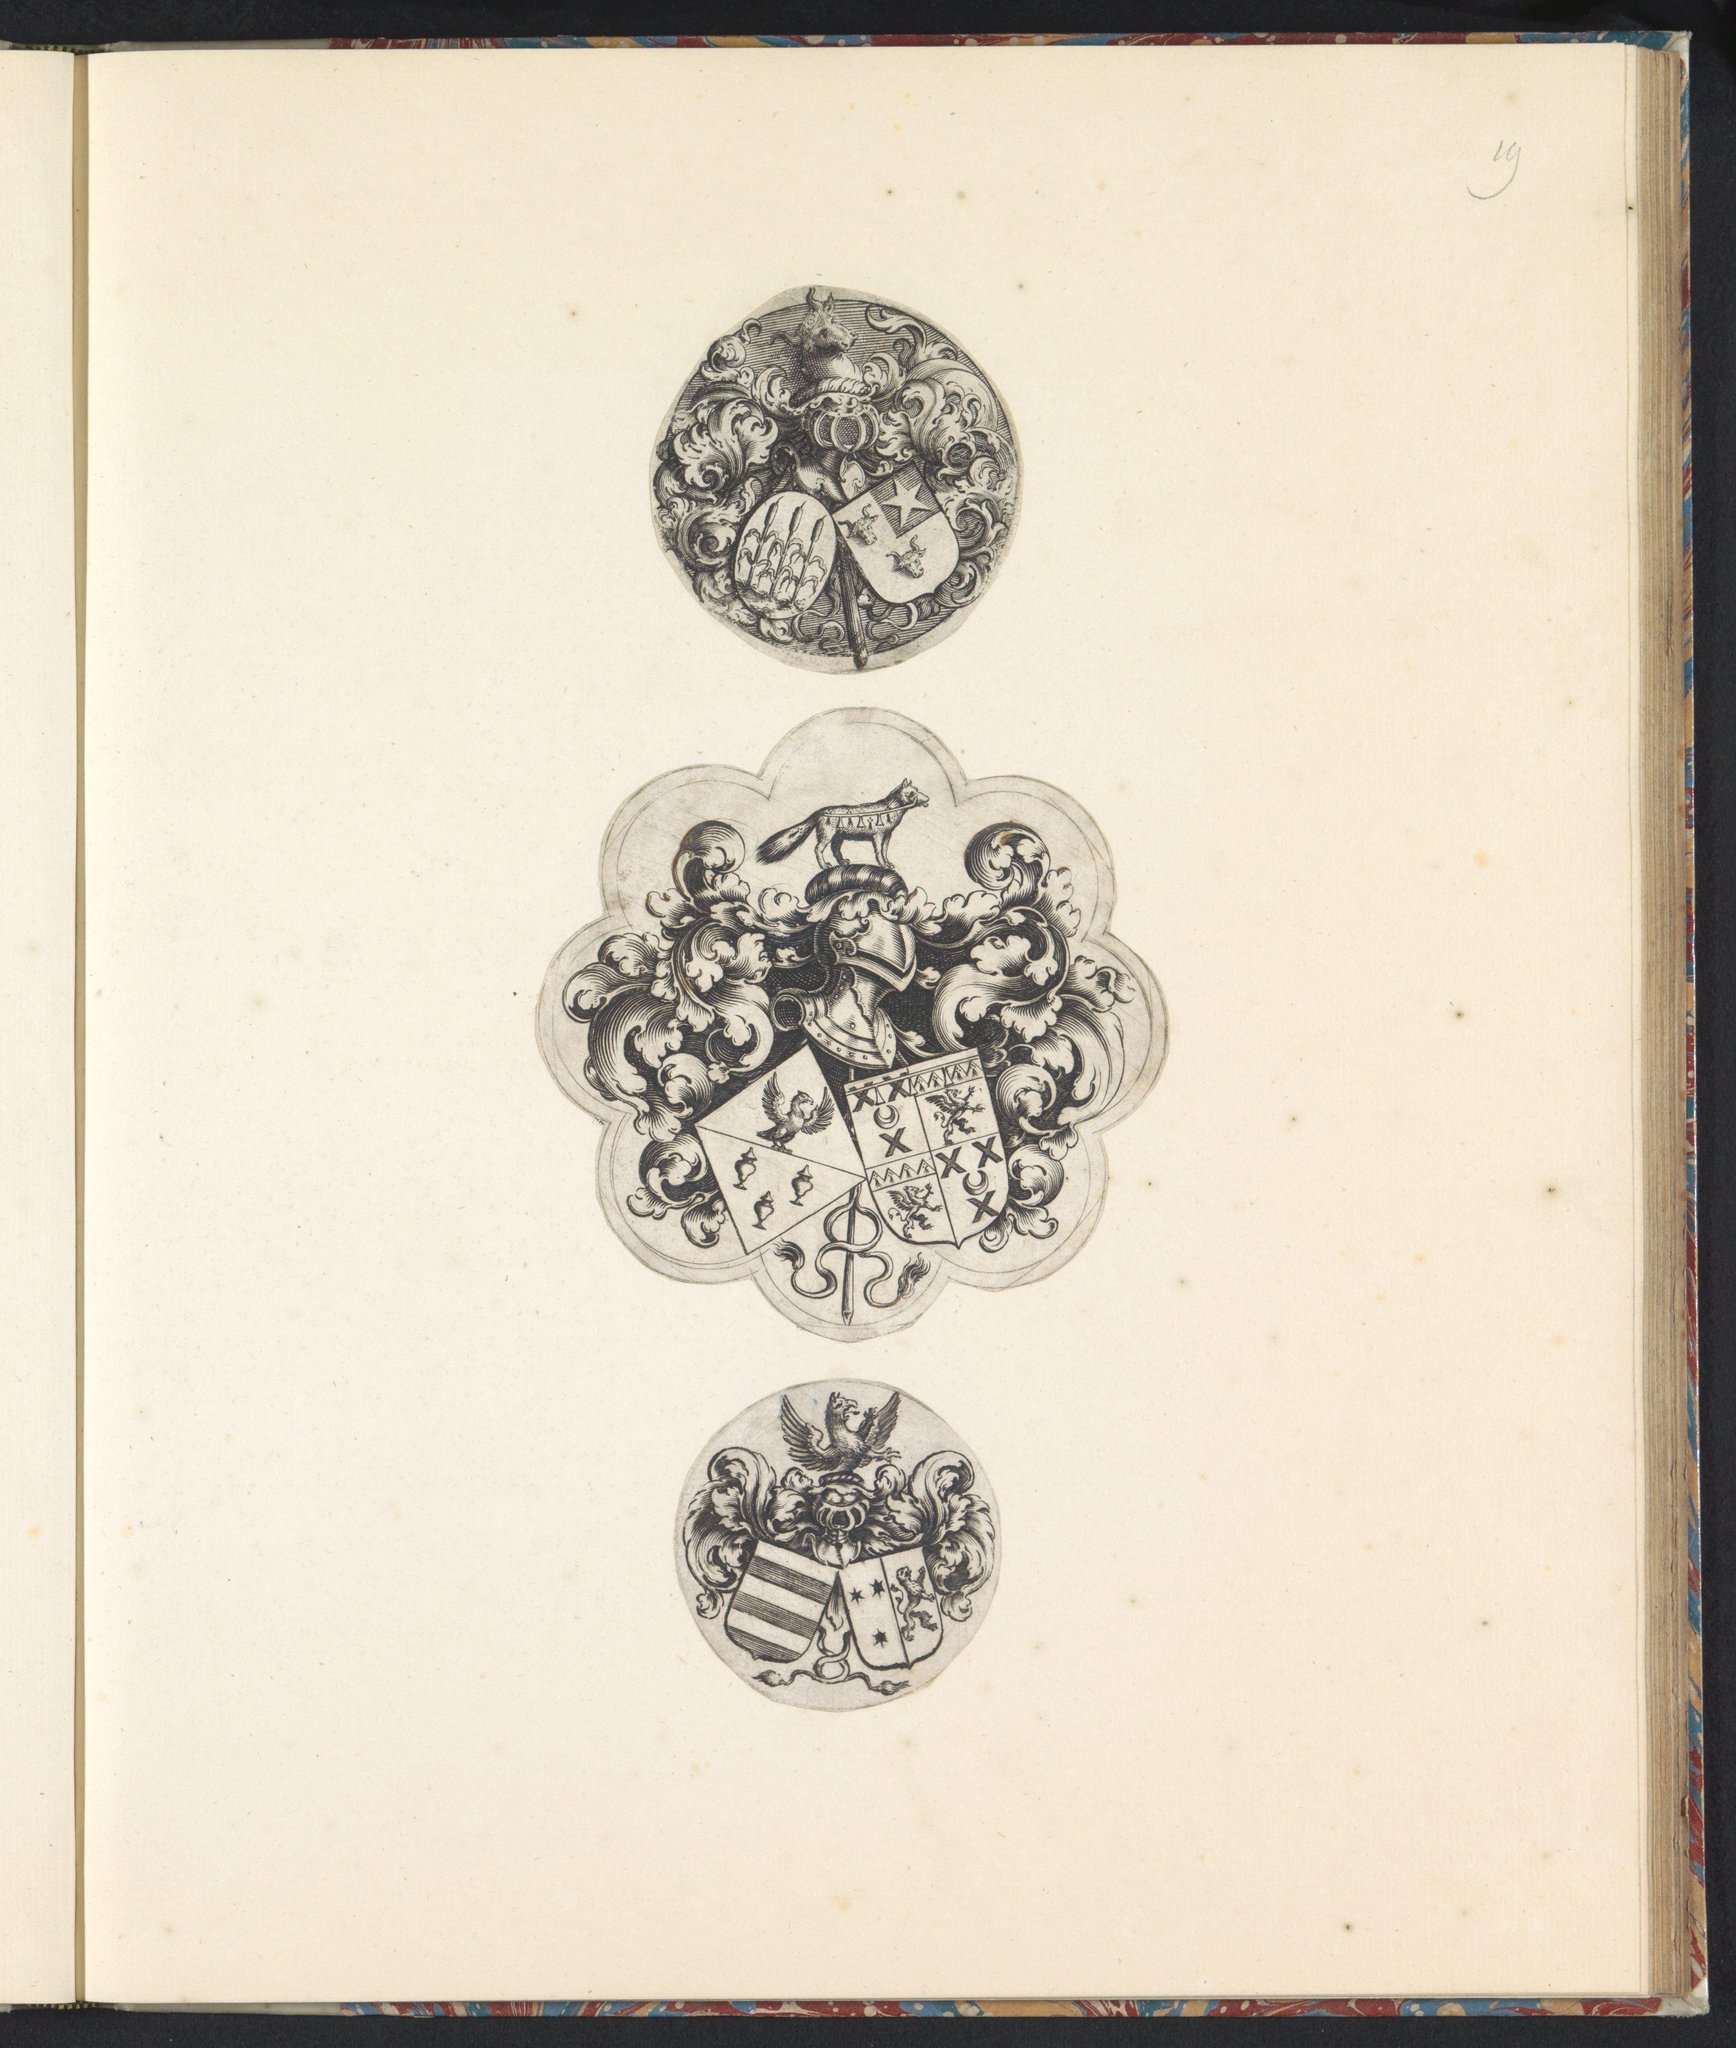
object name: album leaf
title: Drie wapens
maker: Anonymous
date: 1600-1699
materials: paper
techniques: engraving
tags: armorial bearing, heraldry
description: Drie voorstellingen op een albumblad. Bovenaan een wapen met dubbel schild. Op het linker schild drie graanhalmen. Op het rechter twee ossenkoppen en een ster. De tweede voorstelling betreft een dubbel schild met vogel, drie kannen, zes kruizen en een griffioen. Als helmteken een vos. Daaronder een dubbel schild met horizontale balken, sterren en een klimmende leeuw. De prenten maken deel uit van een album.